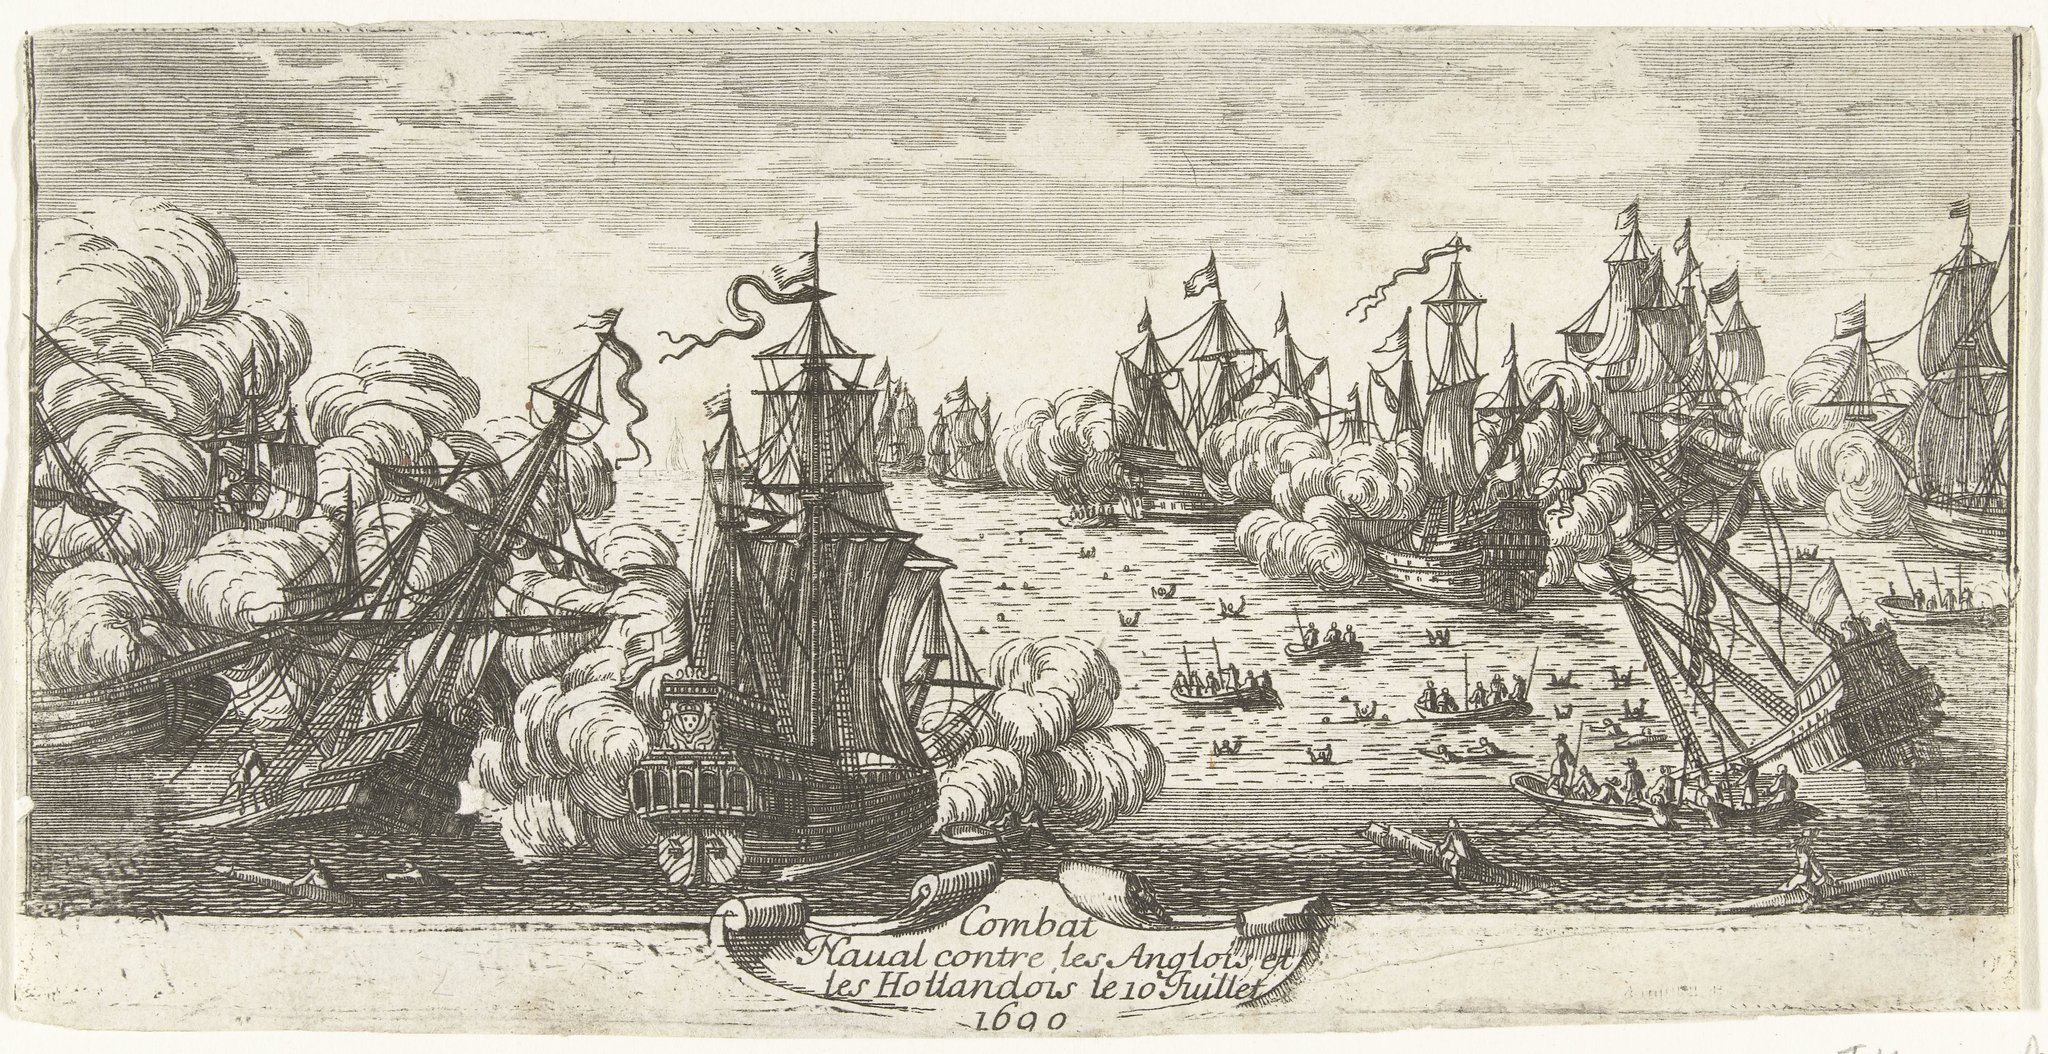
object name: print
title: Combat Naval contre les Anglois et les Hollandois le 10 Juillet 1690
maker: Anonymous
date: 1690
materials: paper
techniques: etching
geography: france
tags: battle (+ naval force), battle of beachy head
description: Zeeslag bij Beachy Head (bij Béveziers) waarbij een gecombineerd Engelse en Nederlandse vloot verslagen werd door de Fransen, 10 juli 1690.